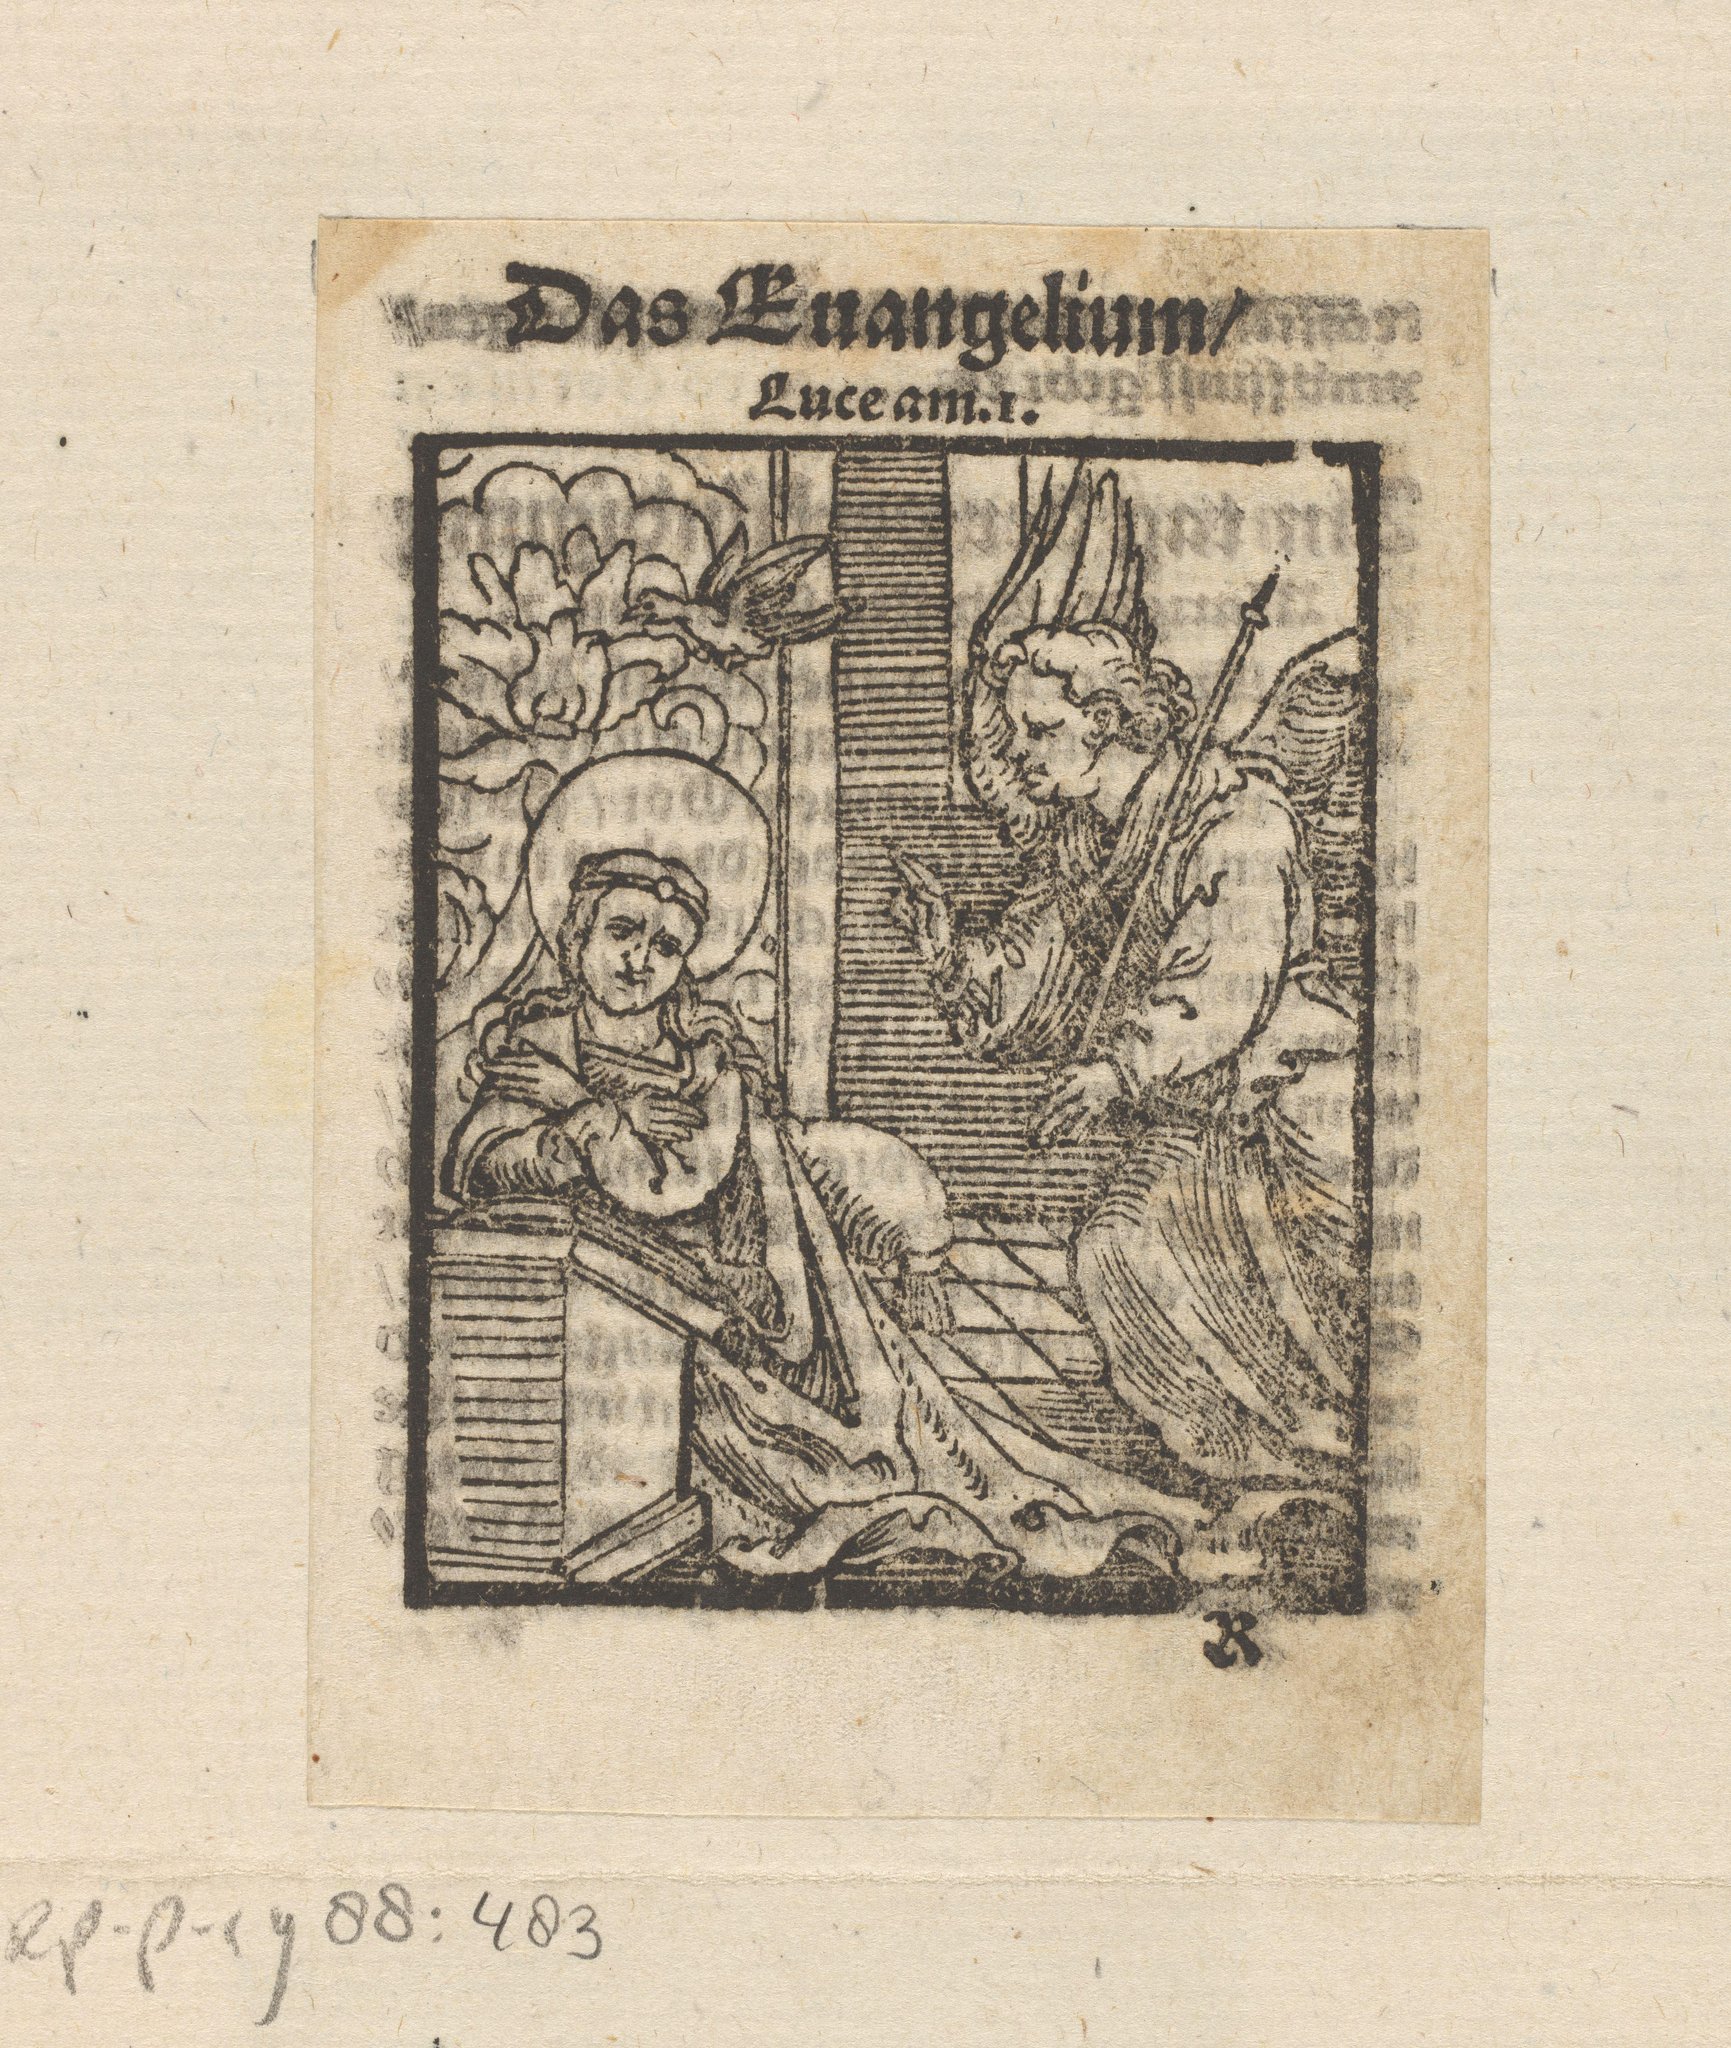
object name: book illustration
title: Annunciatie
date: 1536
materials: paper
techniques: woodcut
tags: the annunciation: mary, usually reading, is visited by the angel (sometimes a woman overhears the conversation)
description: Prent afkomstig uit: Evangelia und Epistel. Neurenberg: Hans Guldenmund, 1536.